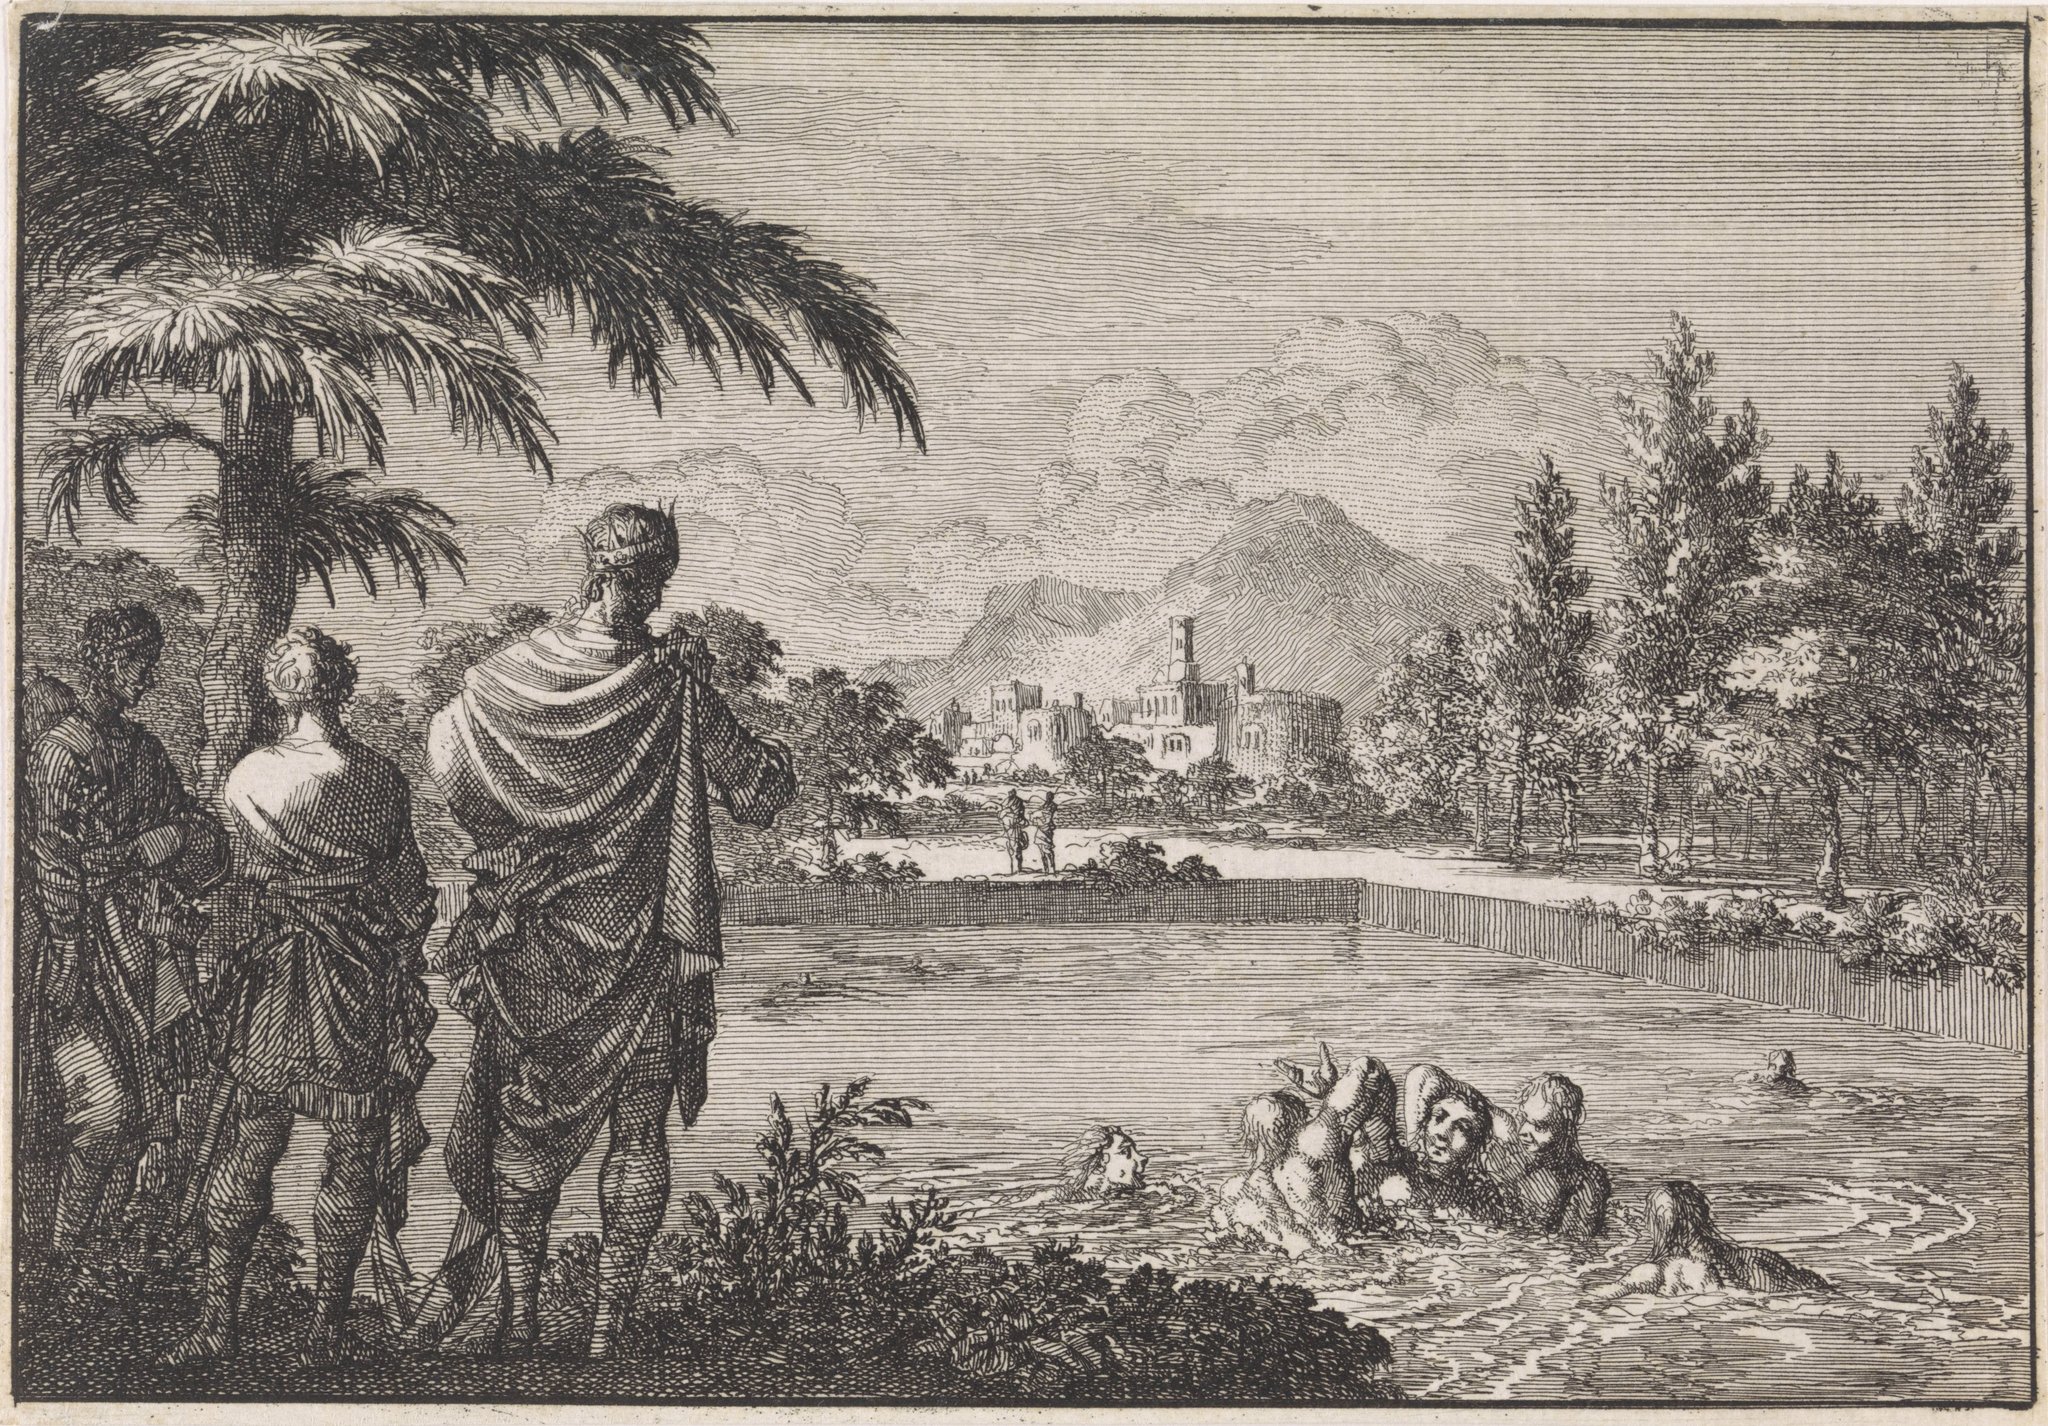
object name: print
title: Herodes doet Aristobulus verdrinken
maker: jan luyken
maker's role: draughtsman, print maker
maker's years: 1649-1712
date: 1704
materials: paper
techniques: etching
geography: amsterdam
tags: violent death ~ water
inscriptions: collector's mark: Lugt 2228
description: Prent ook gebruikt als boekillustratie in: Josephus, Flavius. Alle de Werken, 2 delen. Amsterdam: Pieter Mortier, 1704, dl. 1, p. 362.